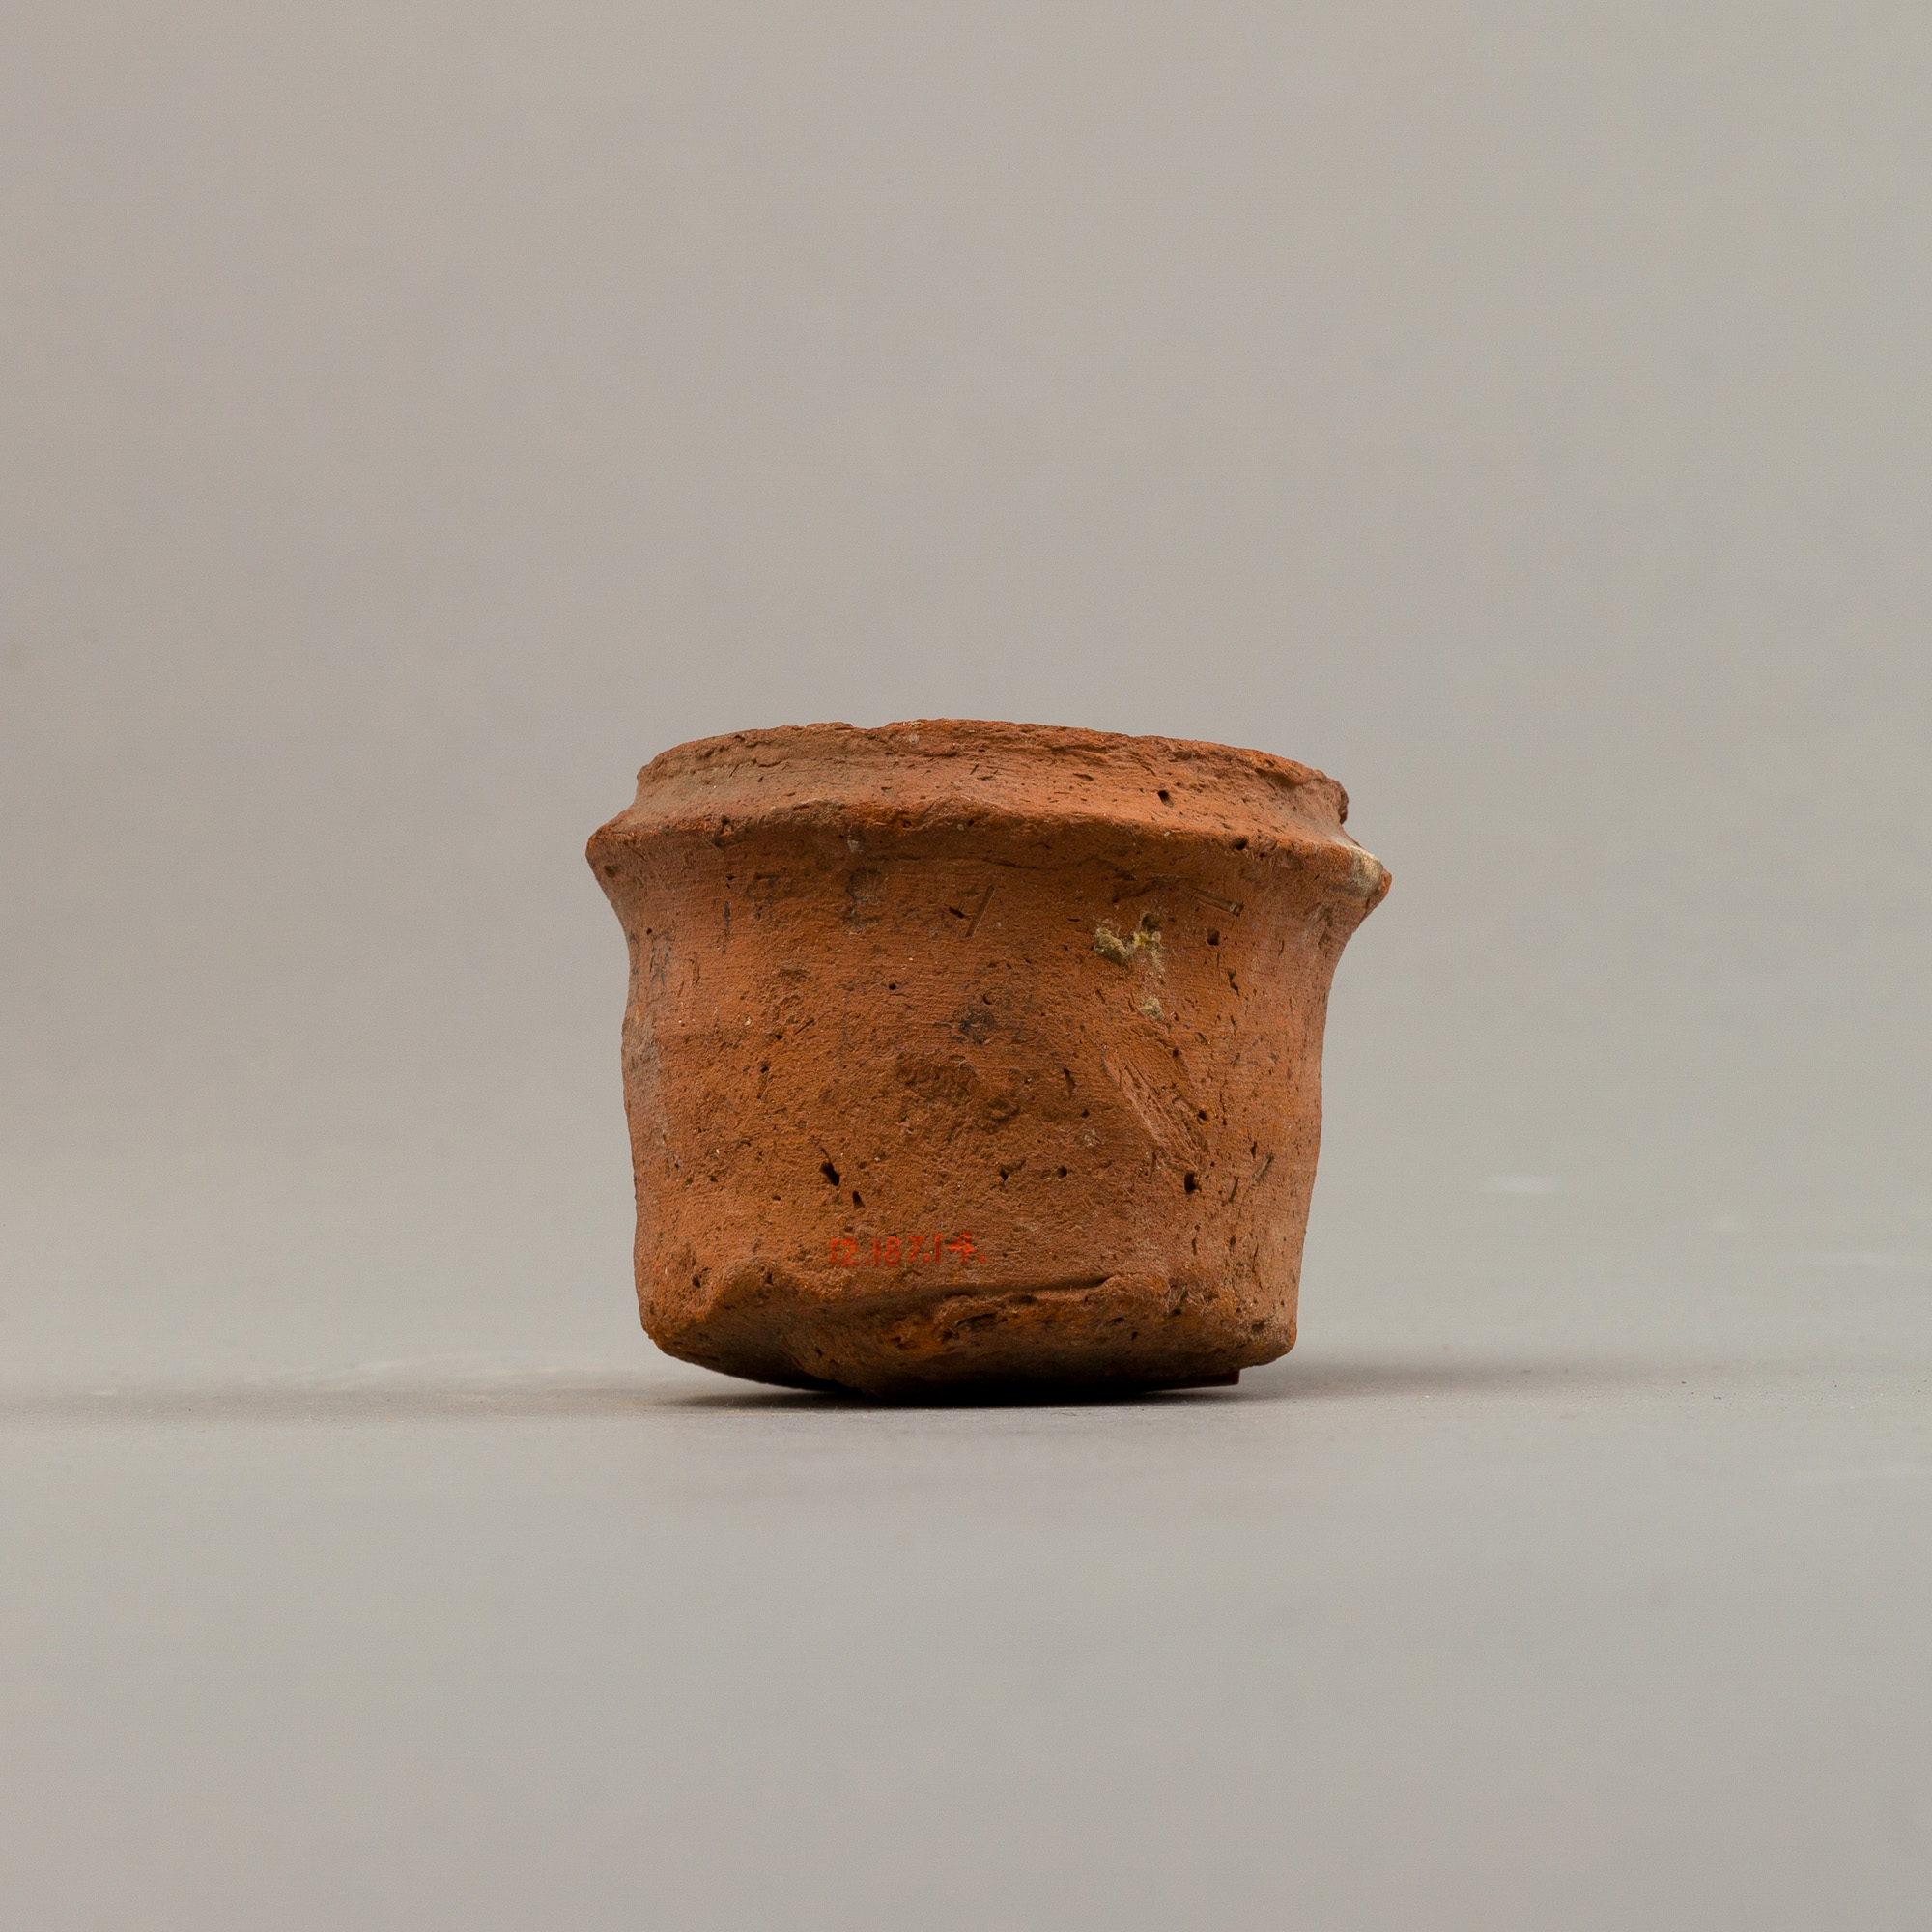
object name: jar, cylindrical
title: Short cylindrical jar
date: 3100-2649 BCE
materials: pottery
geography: egypt